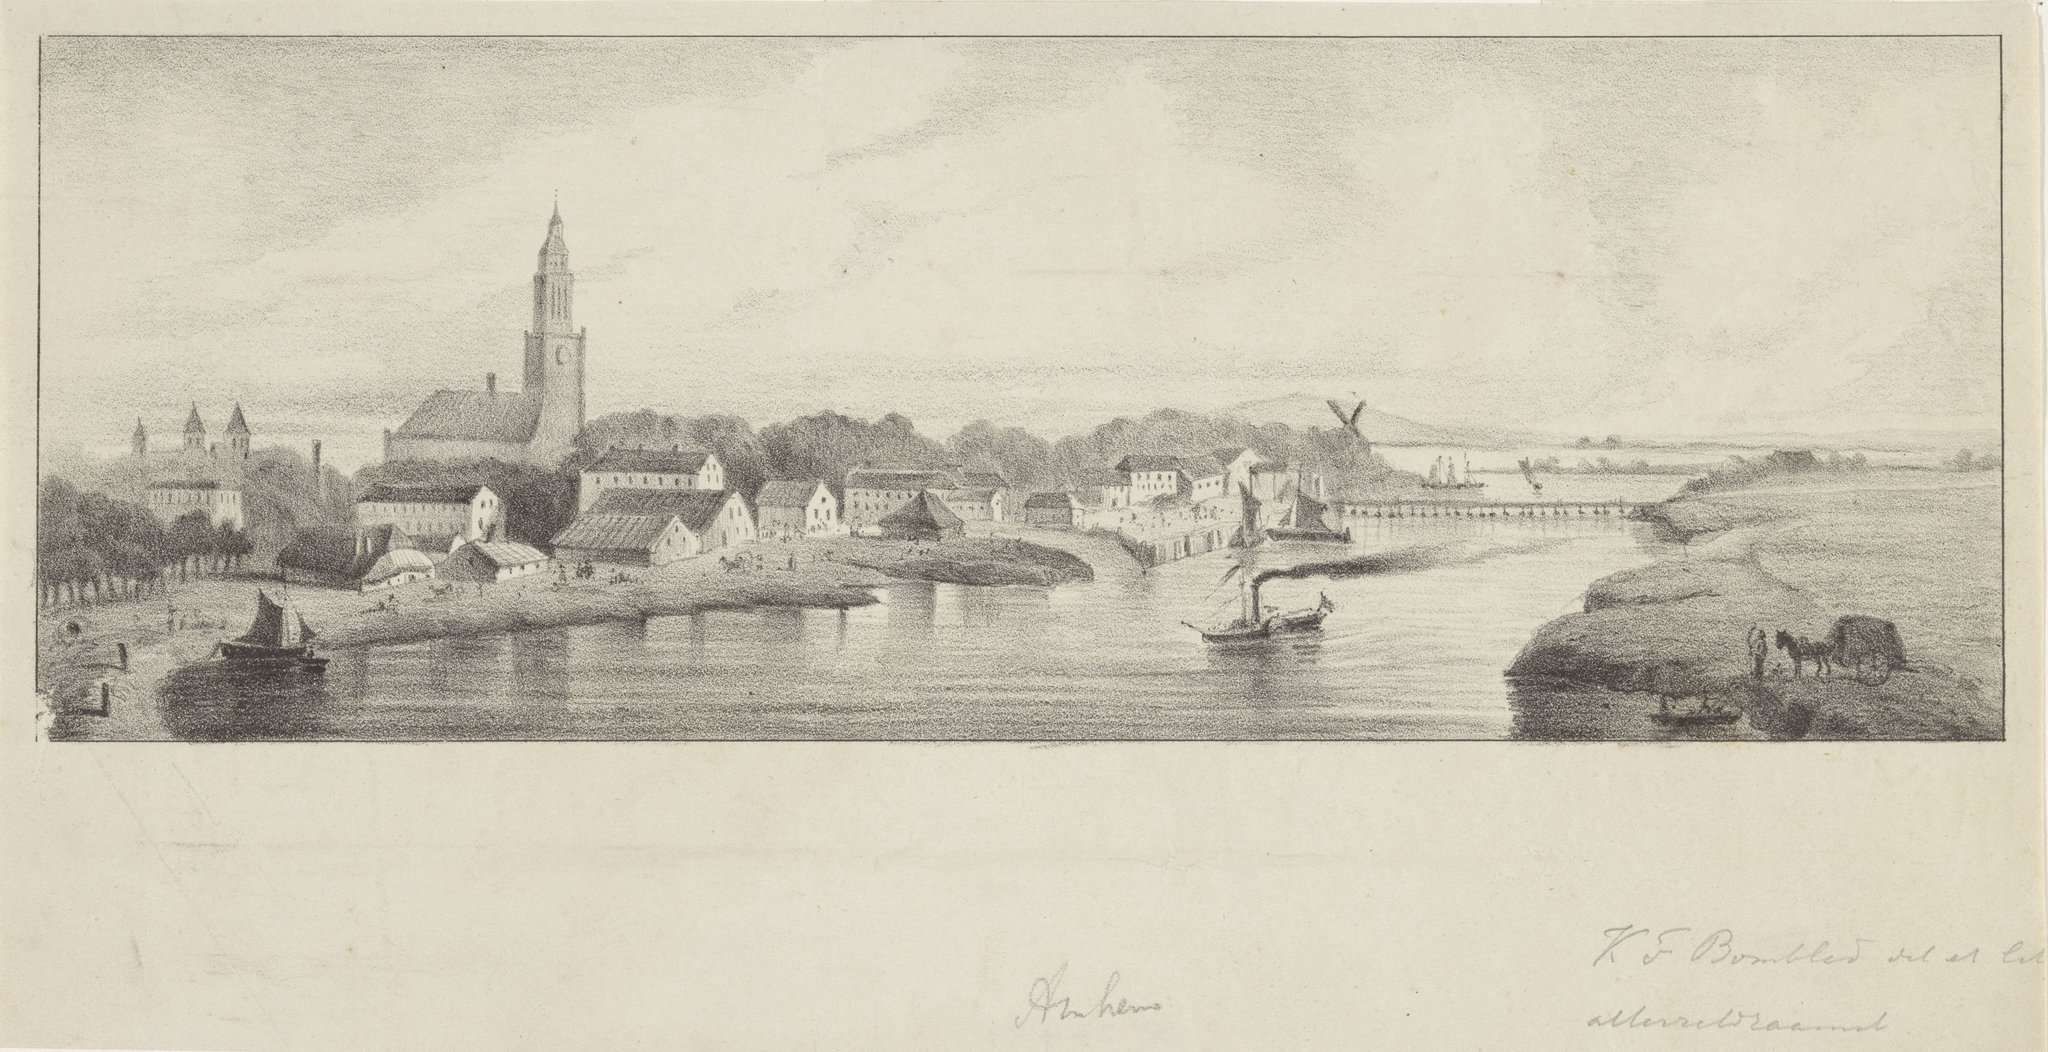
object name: print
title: Gezicht op Arnhem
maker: karel frederik bombled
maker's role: draughtsman, print maker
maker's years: 1822-1902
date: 1832-1902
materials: paper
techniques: lithograph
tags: river, landscapes in the temperate zone, roman catholic church, two-wheeled vehicle drawn by one animal, steamship, motorship, arnhem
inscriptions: inscription: ‘Arnhem’, inscription: ‘K.F. Bombled del et lit / allerzeldzaamst’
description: Op de linkeroever van de rivier ligt Arnhem. Op de rivier vaart een stoomschip. Op de rechteroever staat een figuur met een paard en wagen bij een boot.